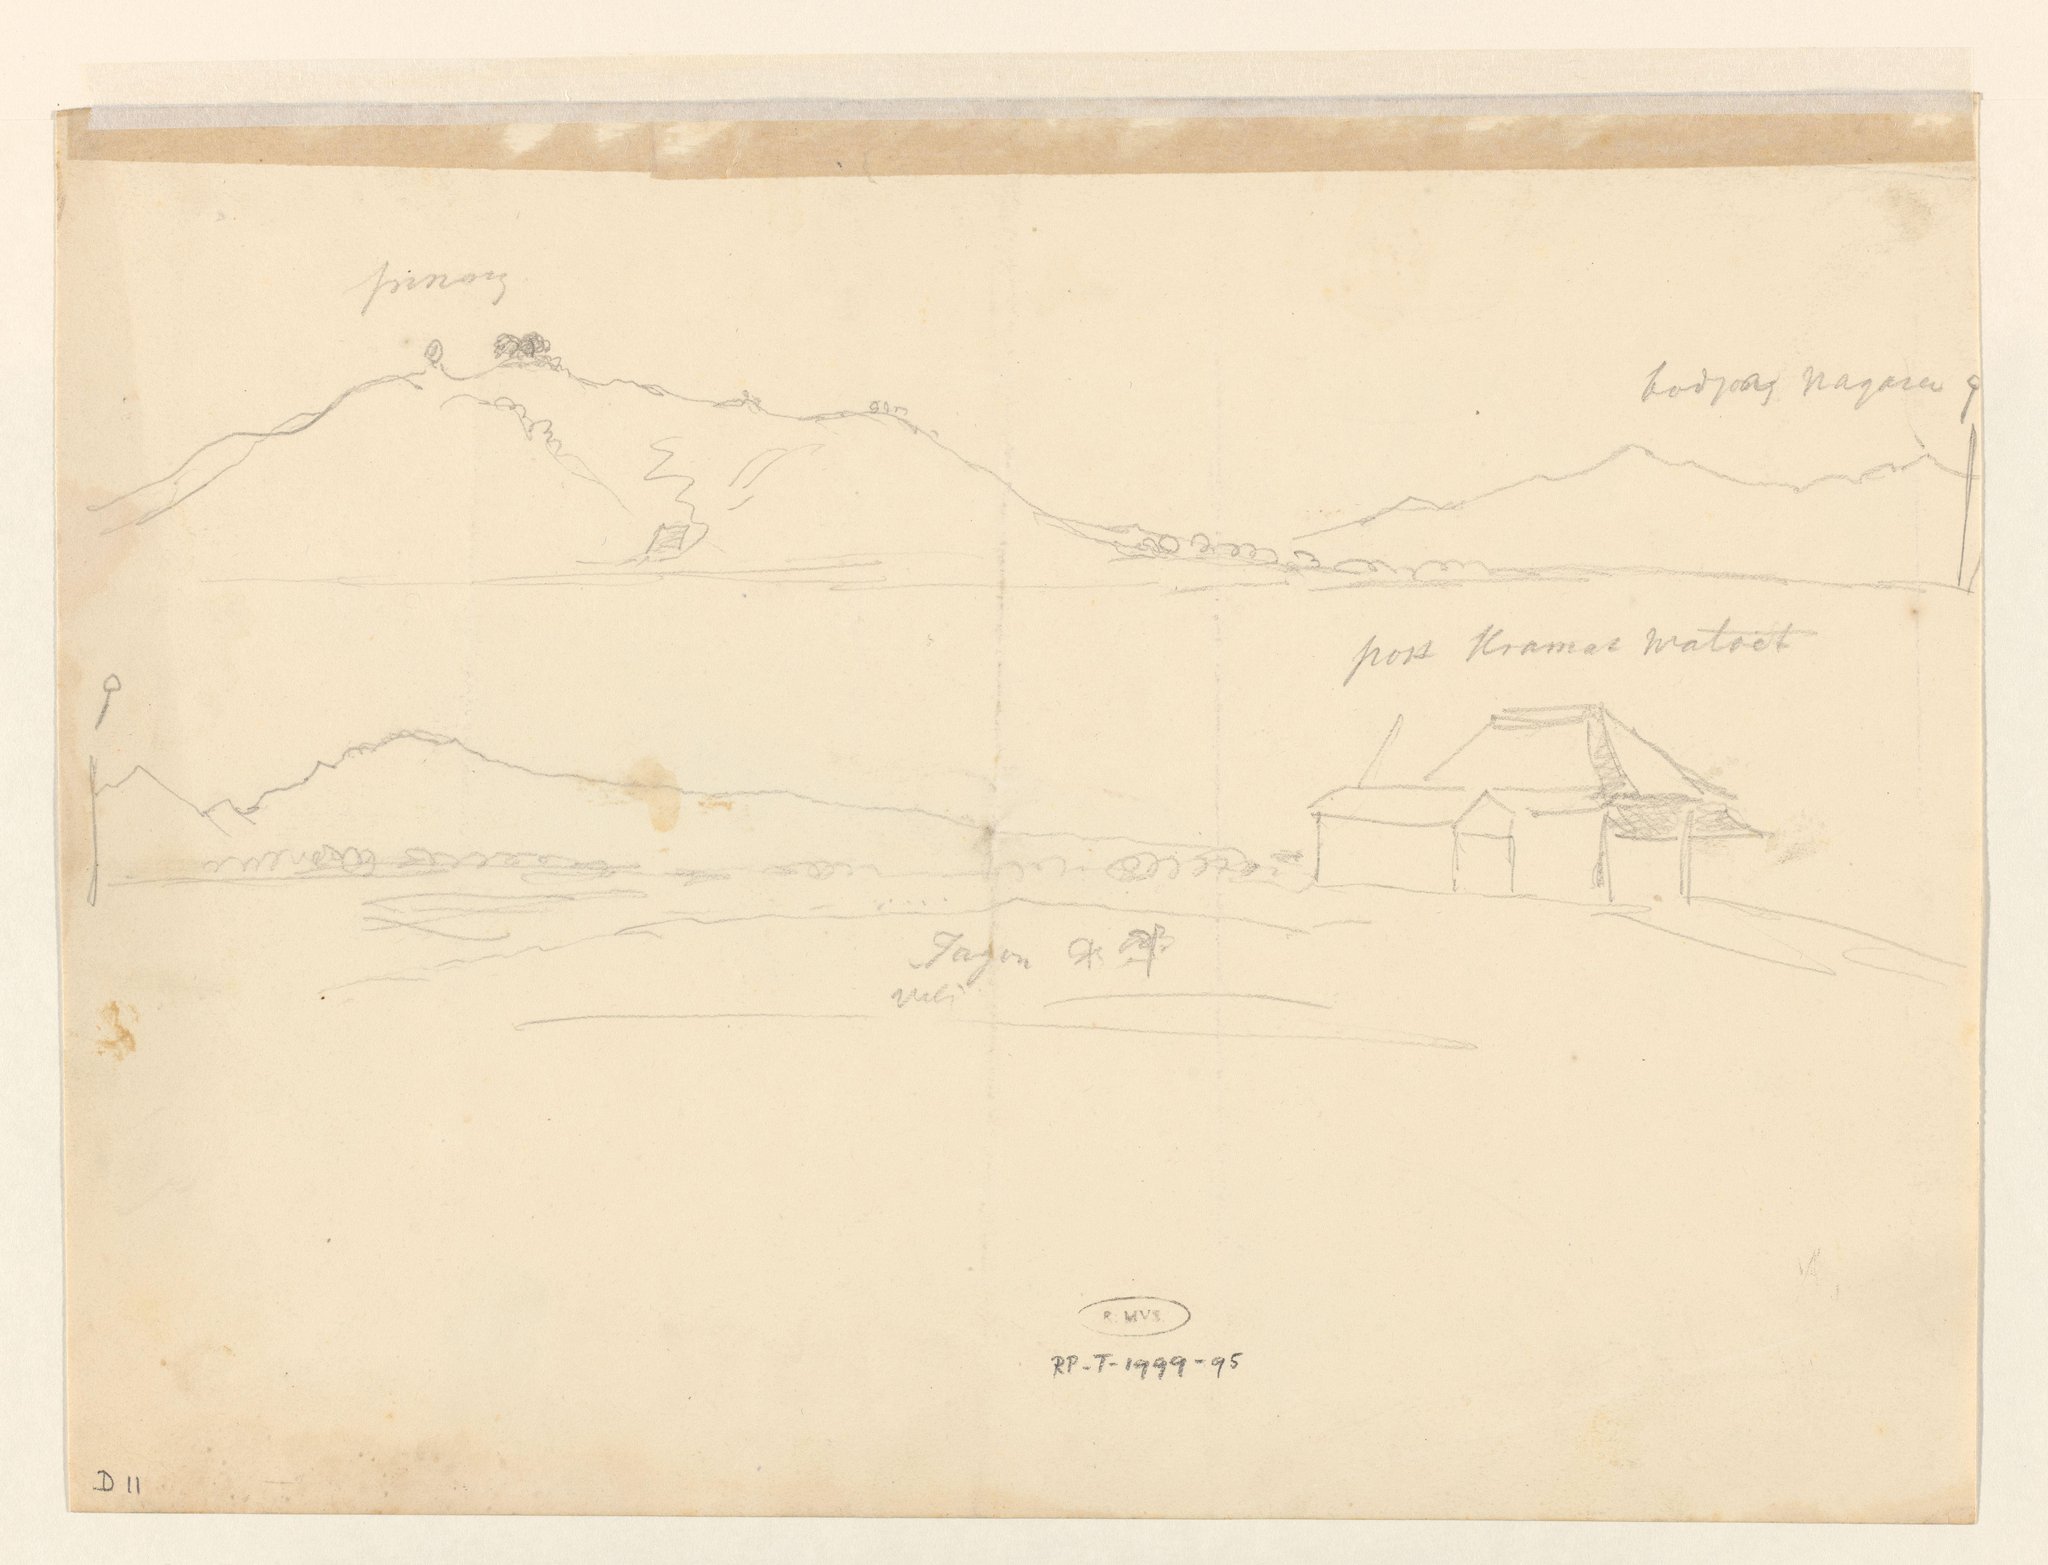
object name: drawing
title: Post Kramat Watoet, bij Batavia, West-Java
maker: adrianus johannes bik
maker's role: draughtsman, print maker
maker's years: 1790-1872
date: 1837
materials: chalk, paper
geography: west java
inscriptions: inscription: ‘Pinang/ Bodjong Nagara/ post Kramat Watoet/ jagon [jagung=maïs]veld’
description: artikel over deze collectie in Bulletin van het Rijksmuseum 49 [2001], nr. 4, pp 342 e.v.